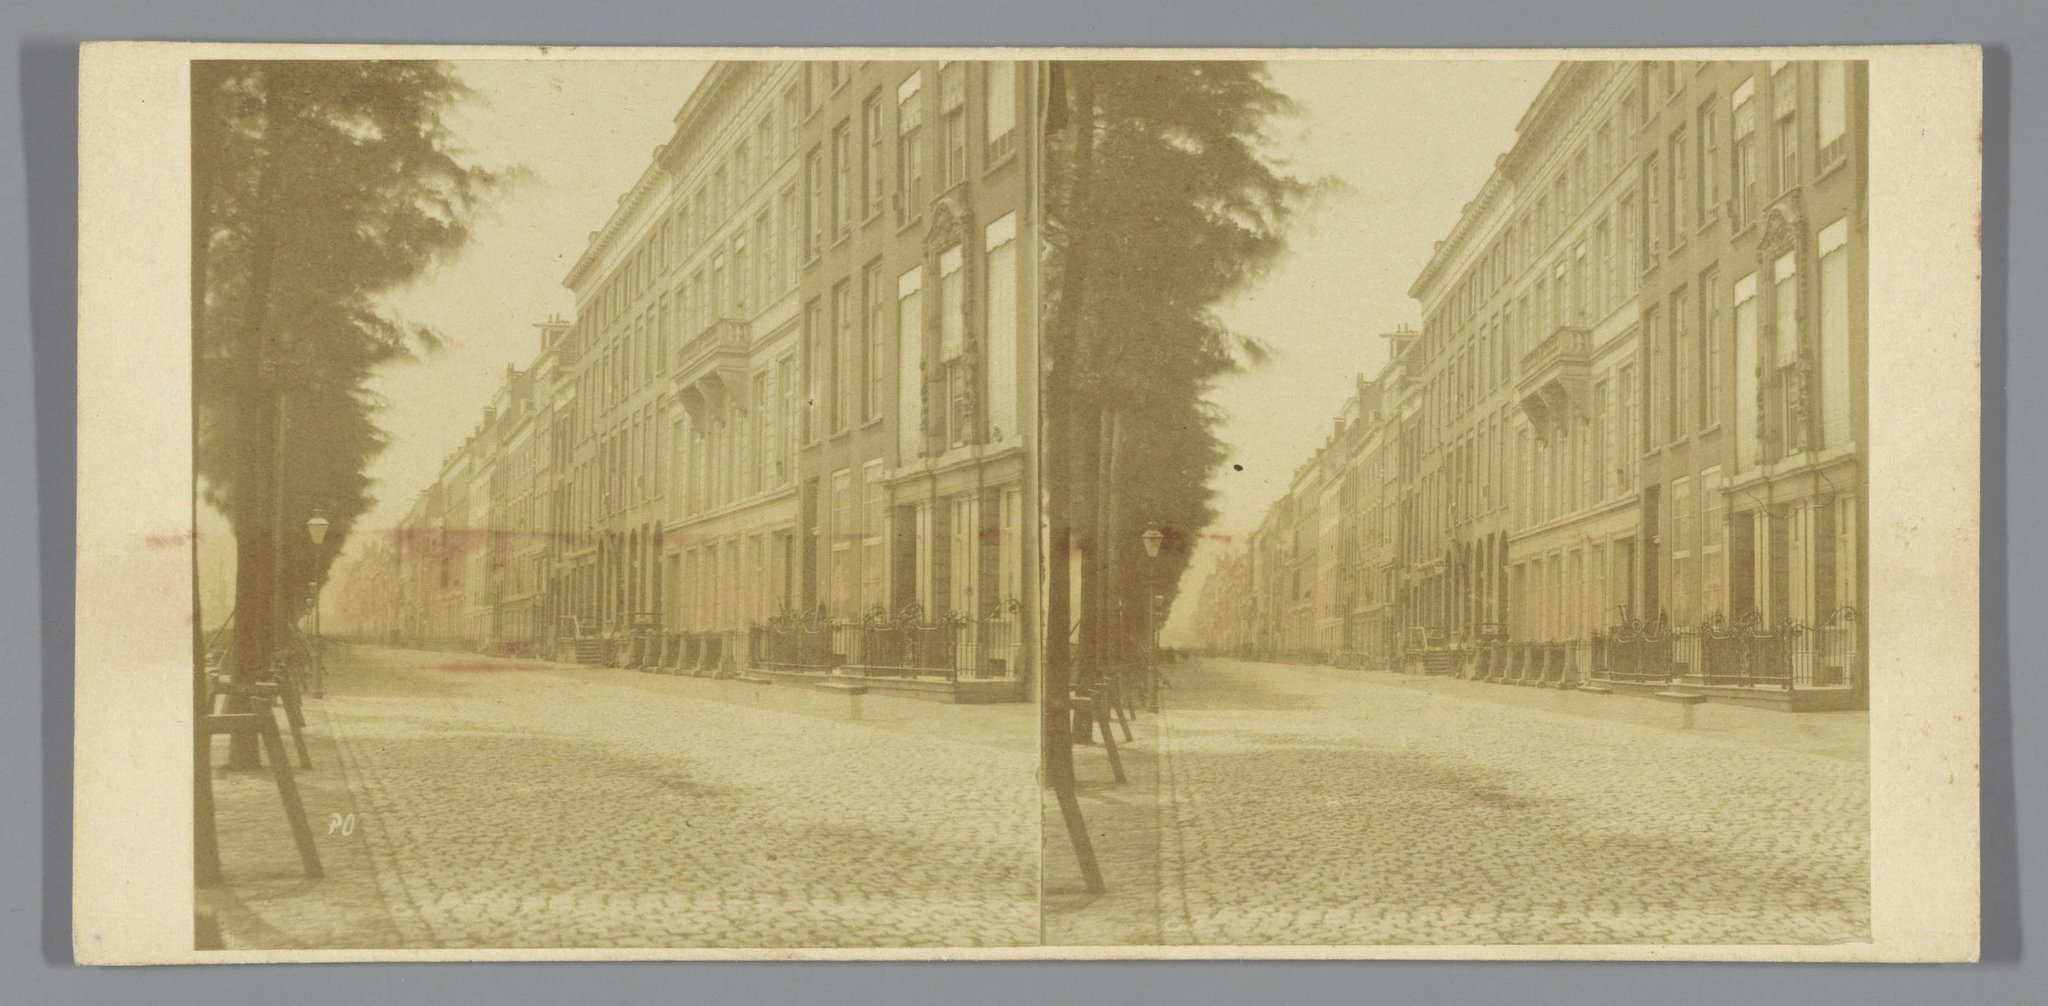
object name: stereograph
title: Vues de Hollande. Rotterdam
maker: pieter oosterhuis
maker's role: draughtsman, print maker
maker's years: 1816-1885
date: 1859-1865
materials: cardboard, paper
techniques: albumen print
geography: rotterdam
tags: street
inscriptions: number: ‘222’, inscription: ‘gesigneerd P(ieter) O(osterhuis)’, initials: ‘P.O.’